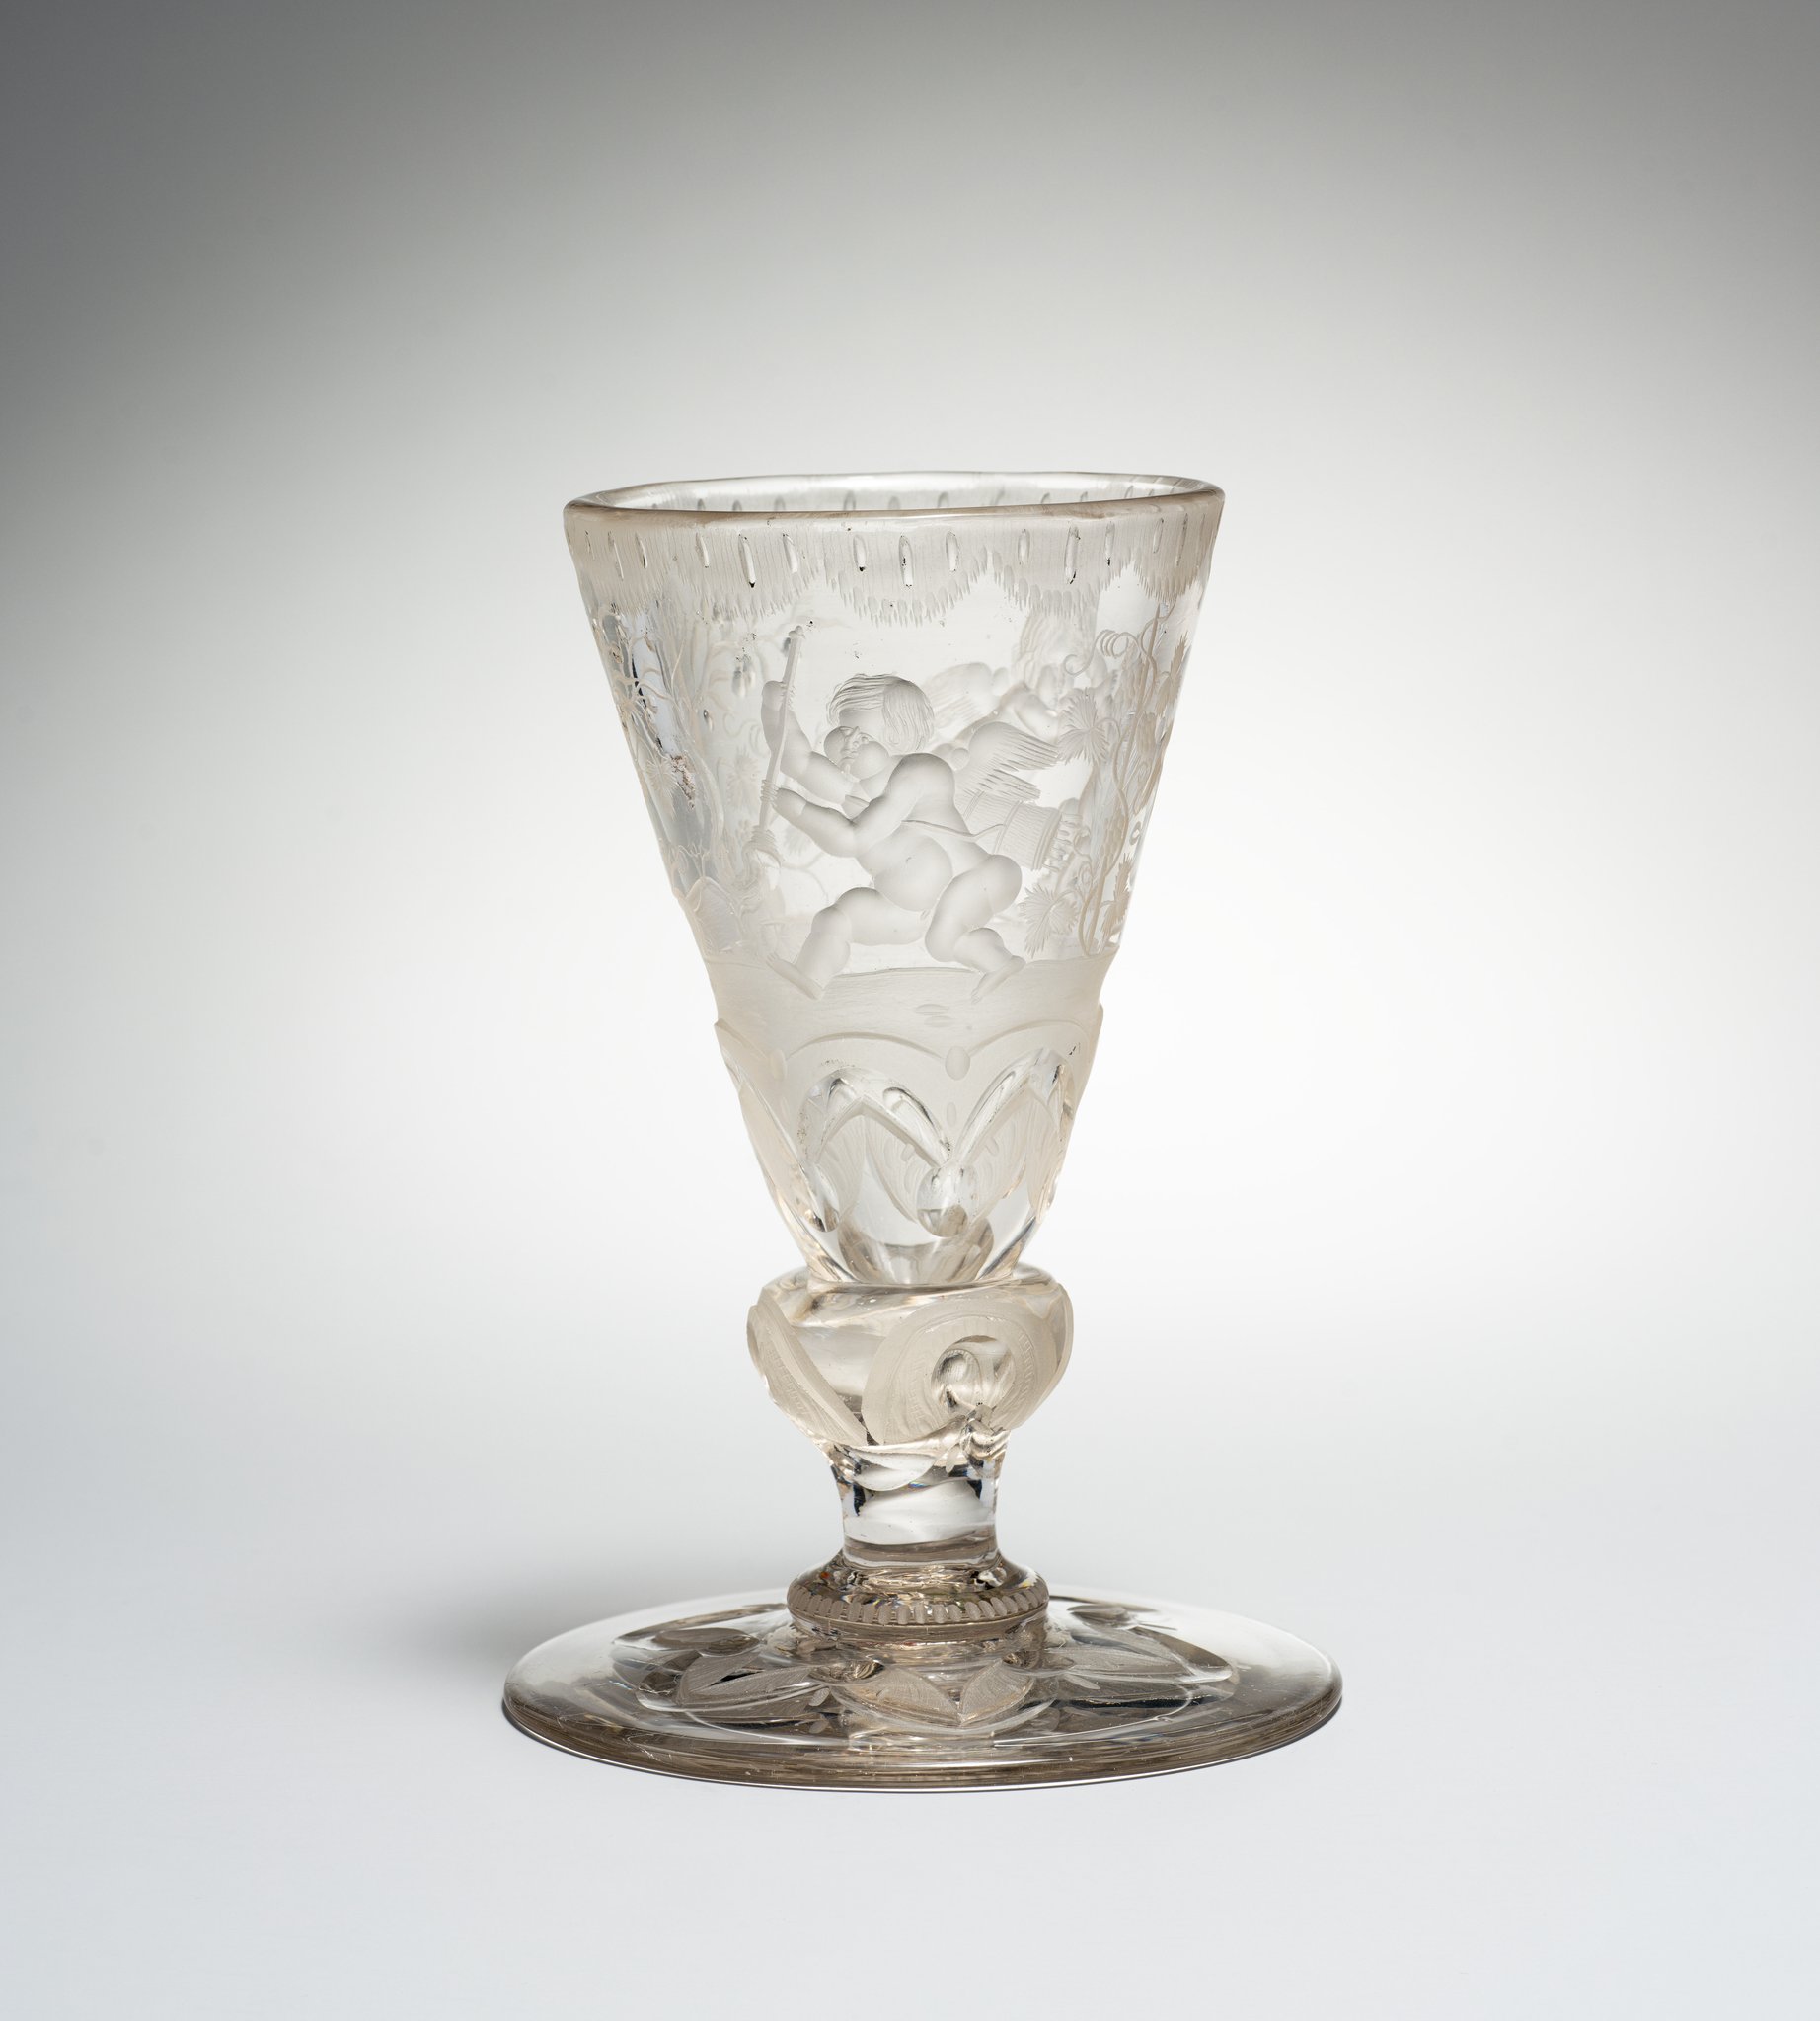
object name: wineglass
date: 1701-1733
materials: glass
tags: putti